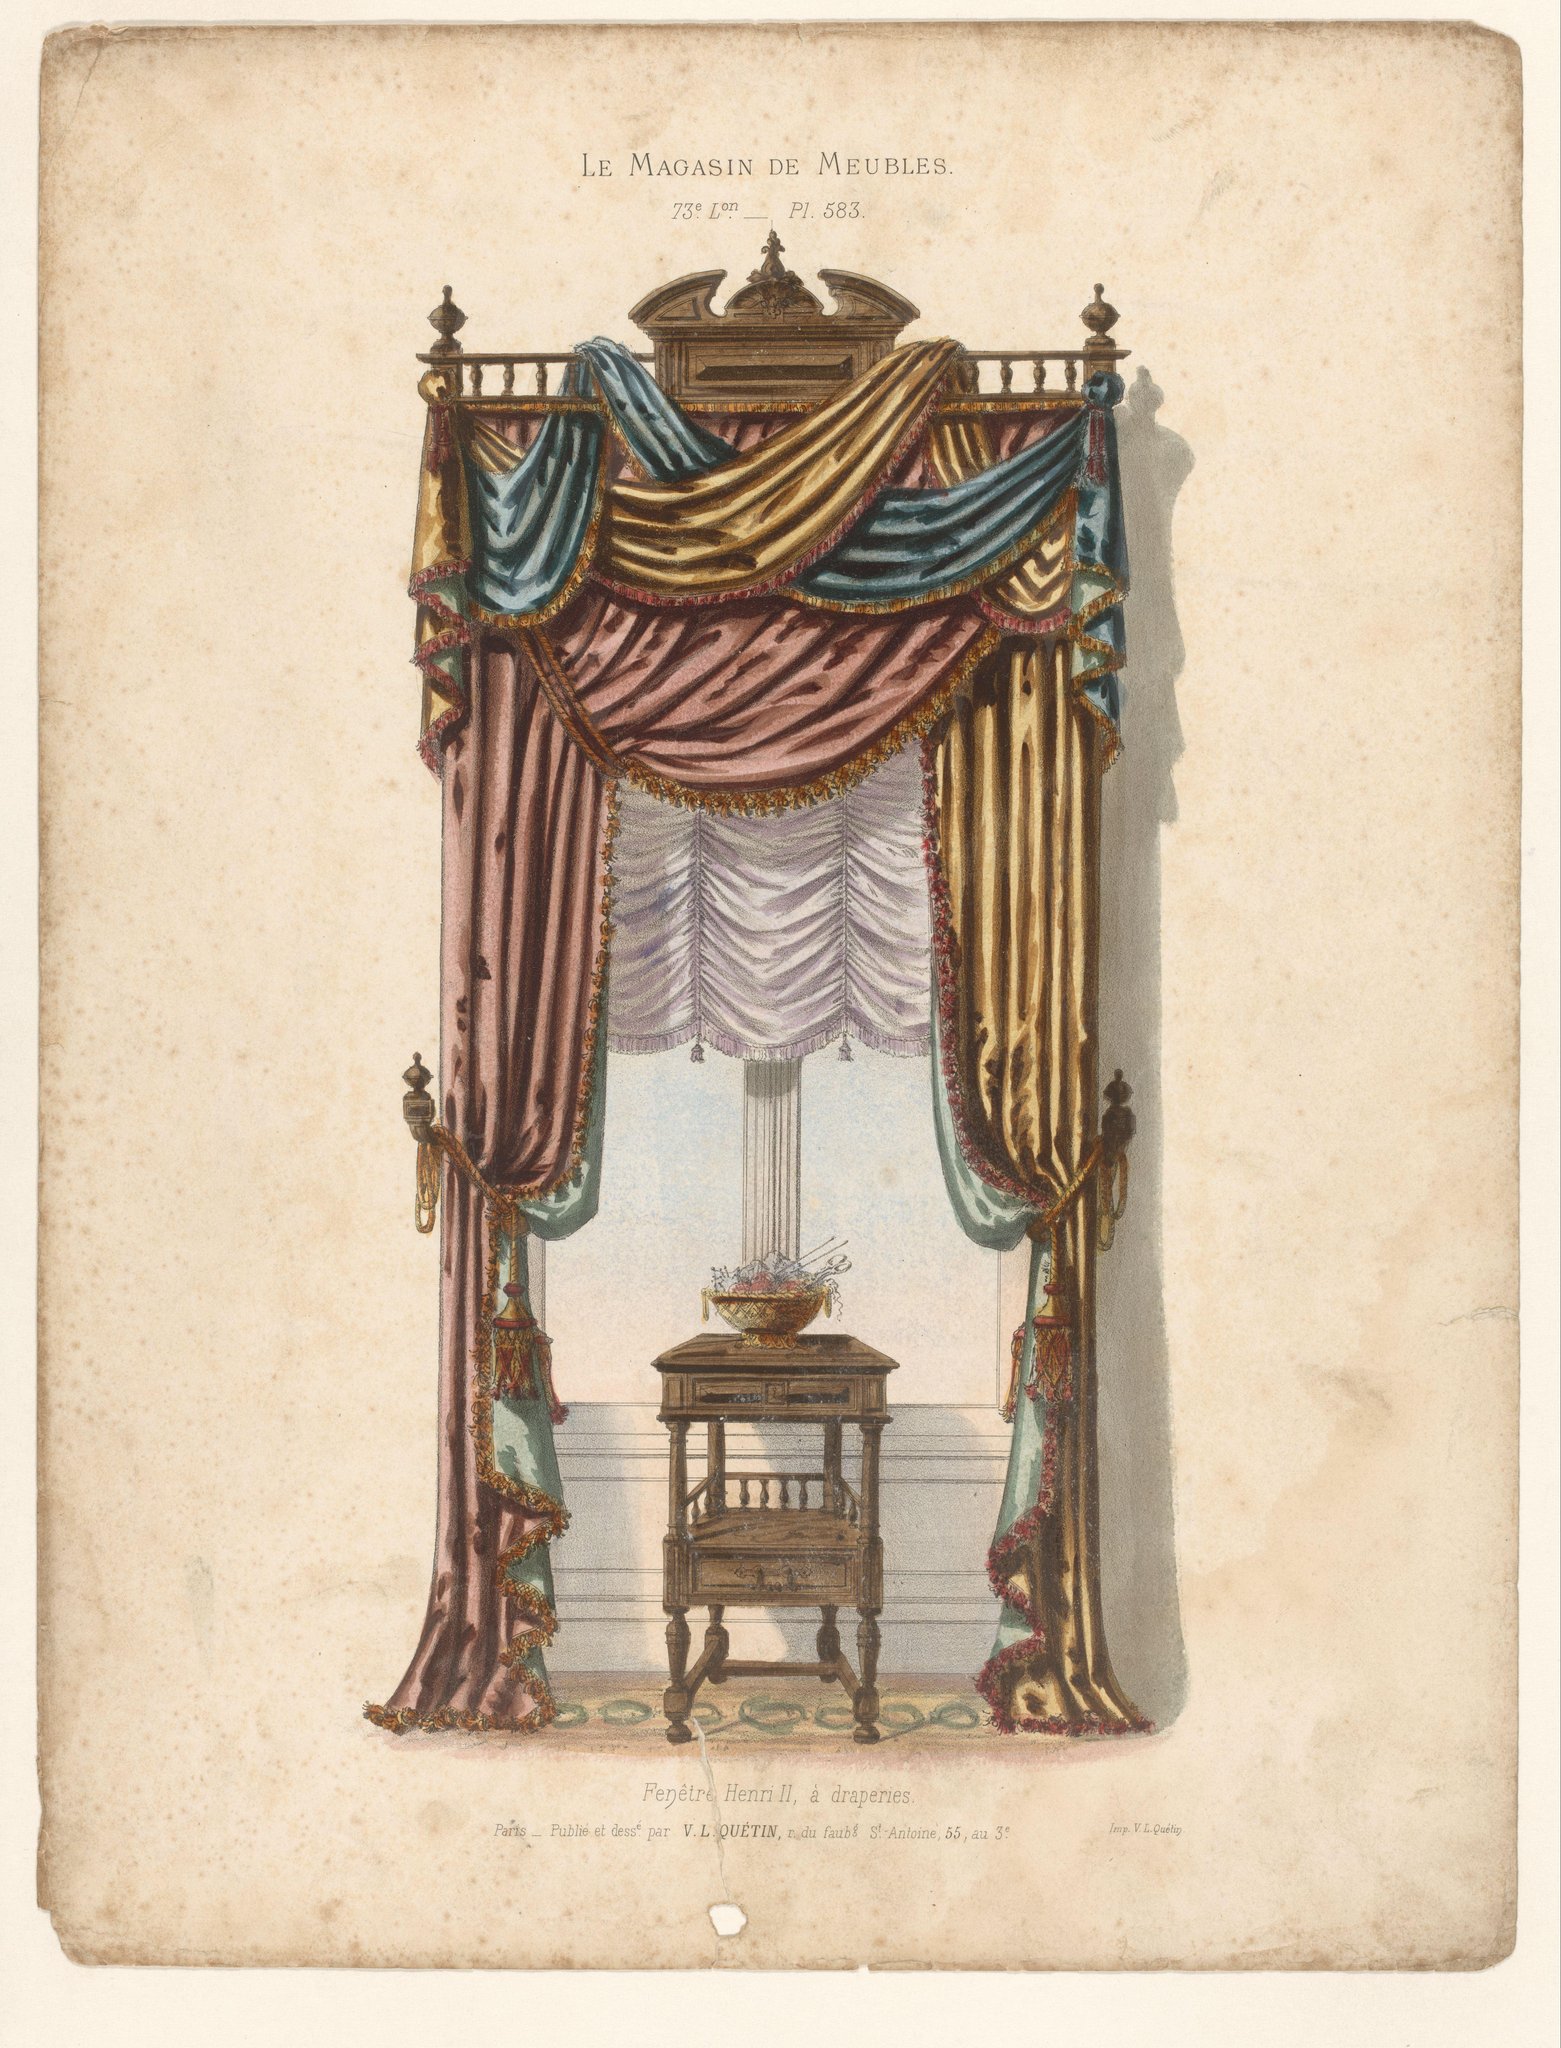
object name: print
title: Venster met gordijnen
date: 1878-1904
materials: paper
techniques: hand coloring, lithograph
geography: paris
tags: window, hangings and drapery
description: Een venster met gedrapeerde gordijnen in de Hendrik II-stijl. Voor het venster staat een mand op een tafel. Prent uit 73e Livraison.